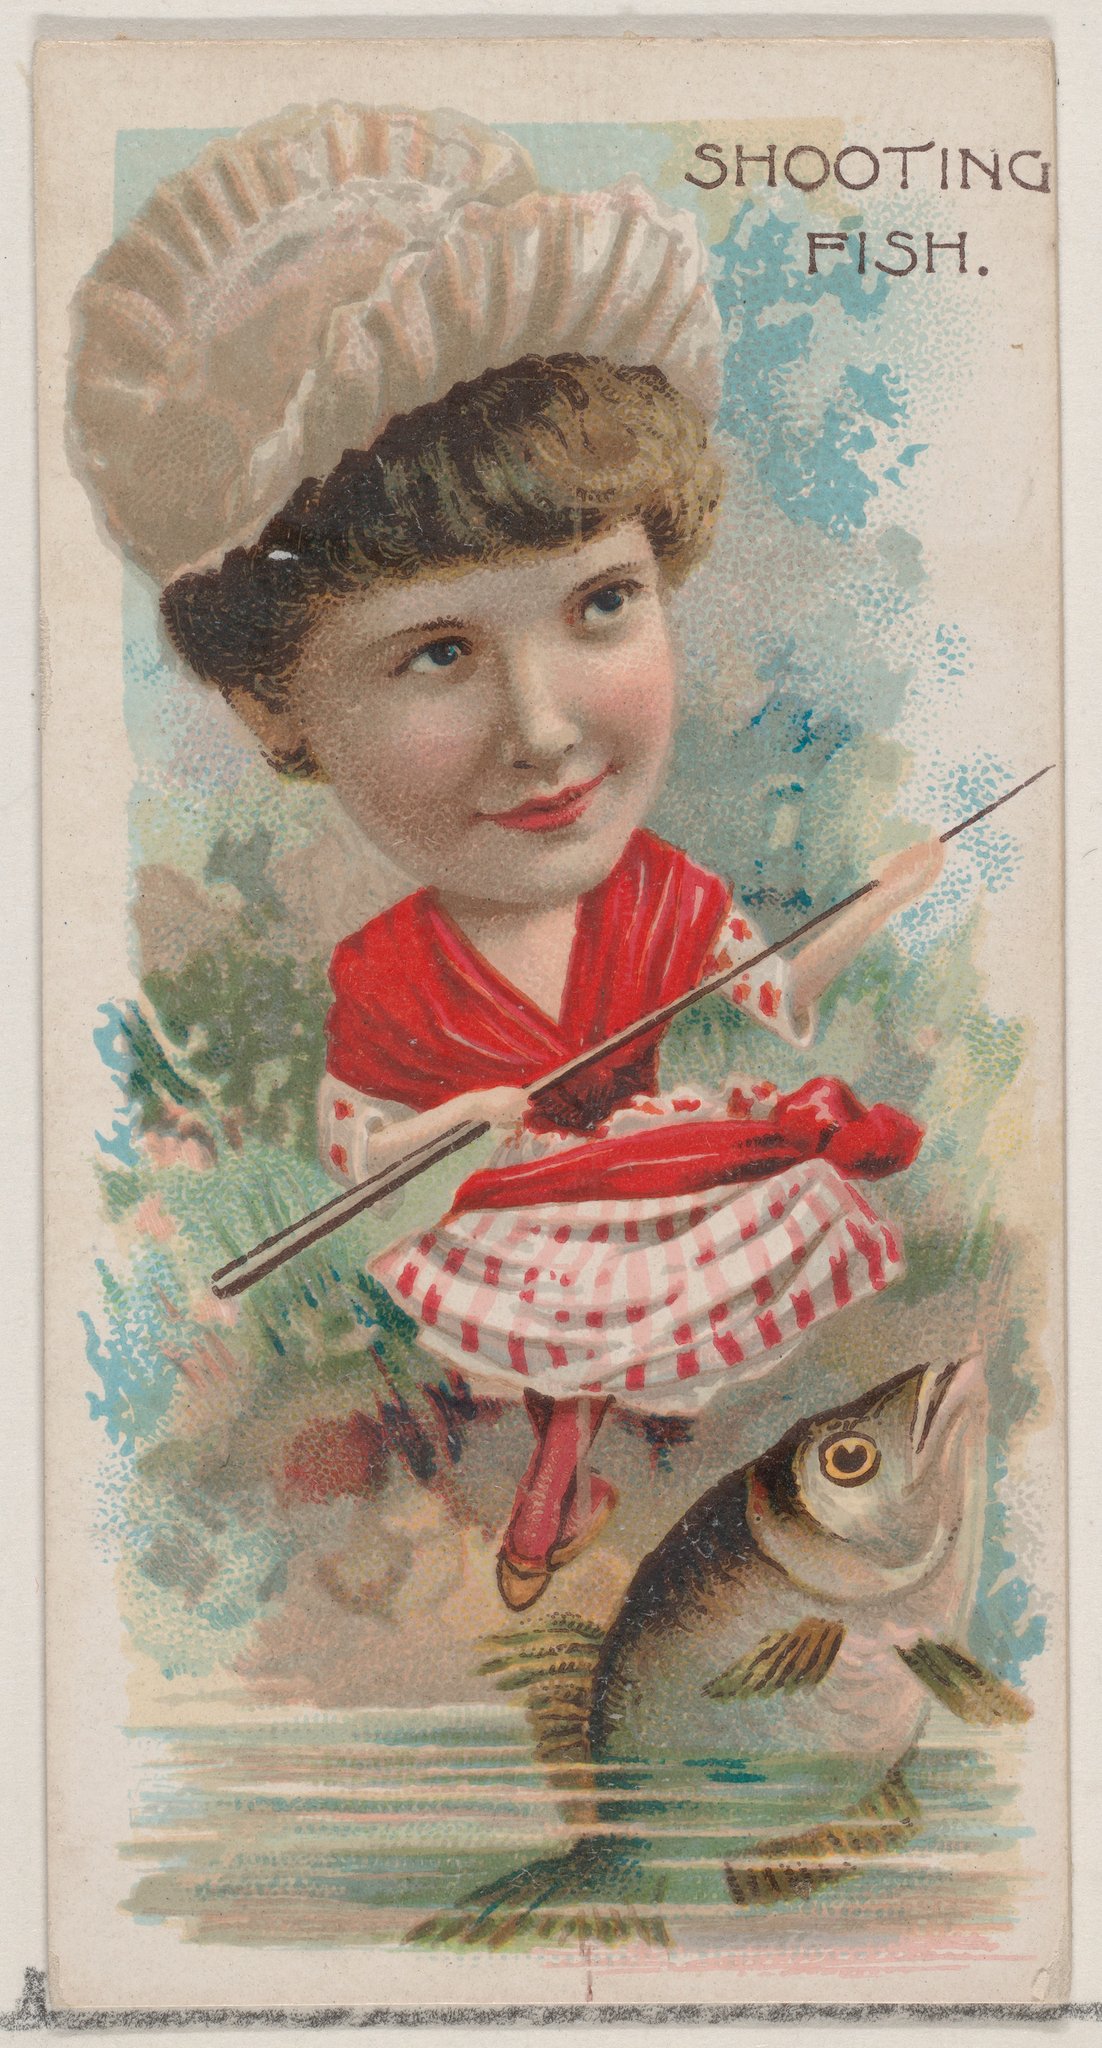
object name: print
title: Shooting Fish, from the series Fishers and Fish (N74) for Duke brand cigarettes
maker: knapp & company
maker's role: lithographer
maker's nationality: american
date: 1888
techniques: color lithograph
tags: women,fishing,fish